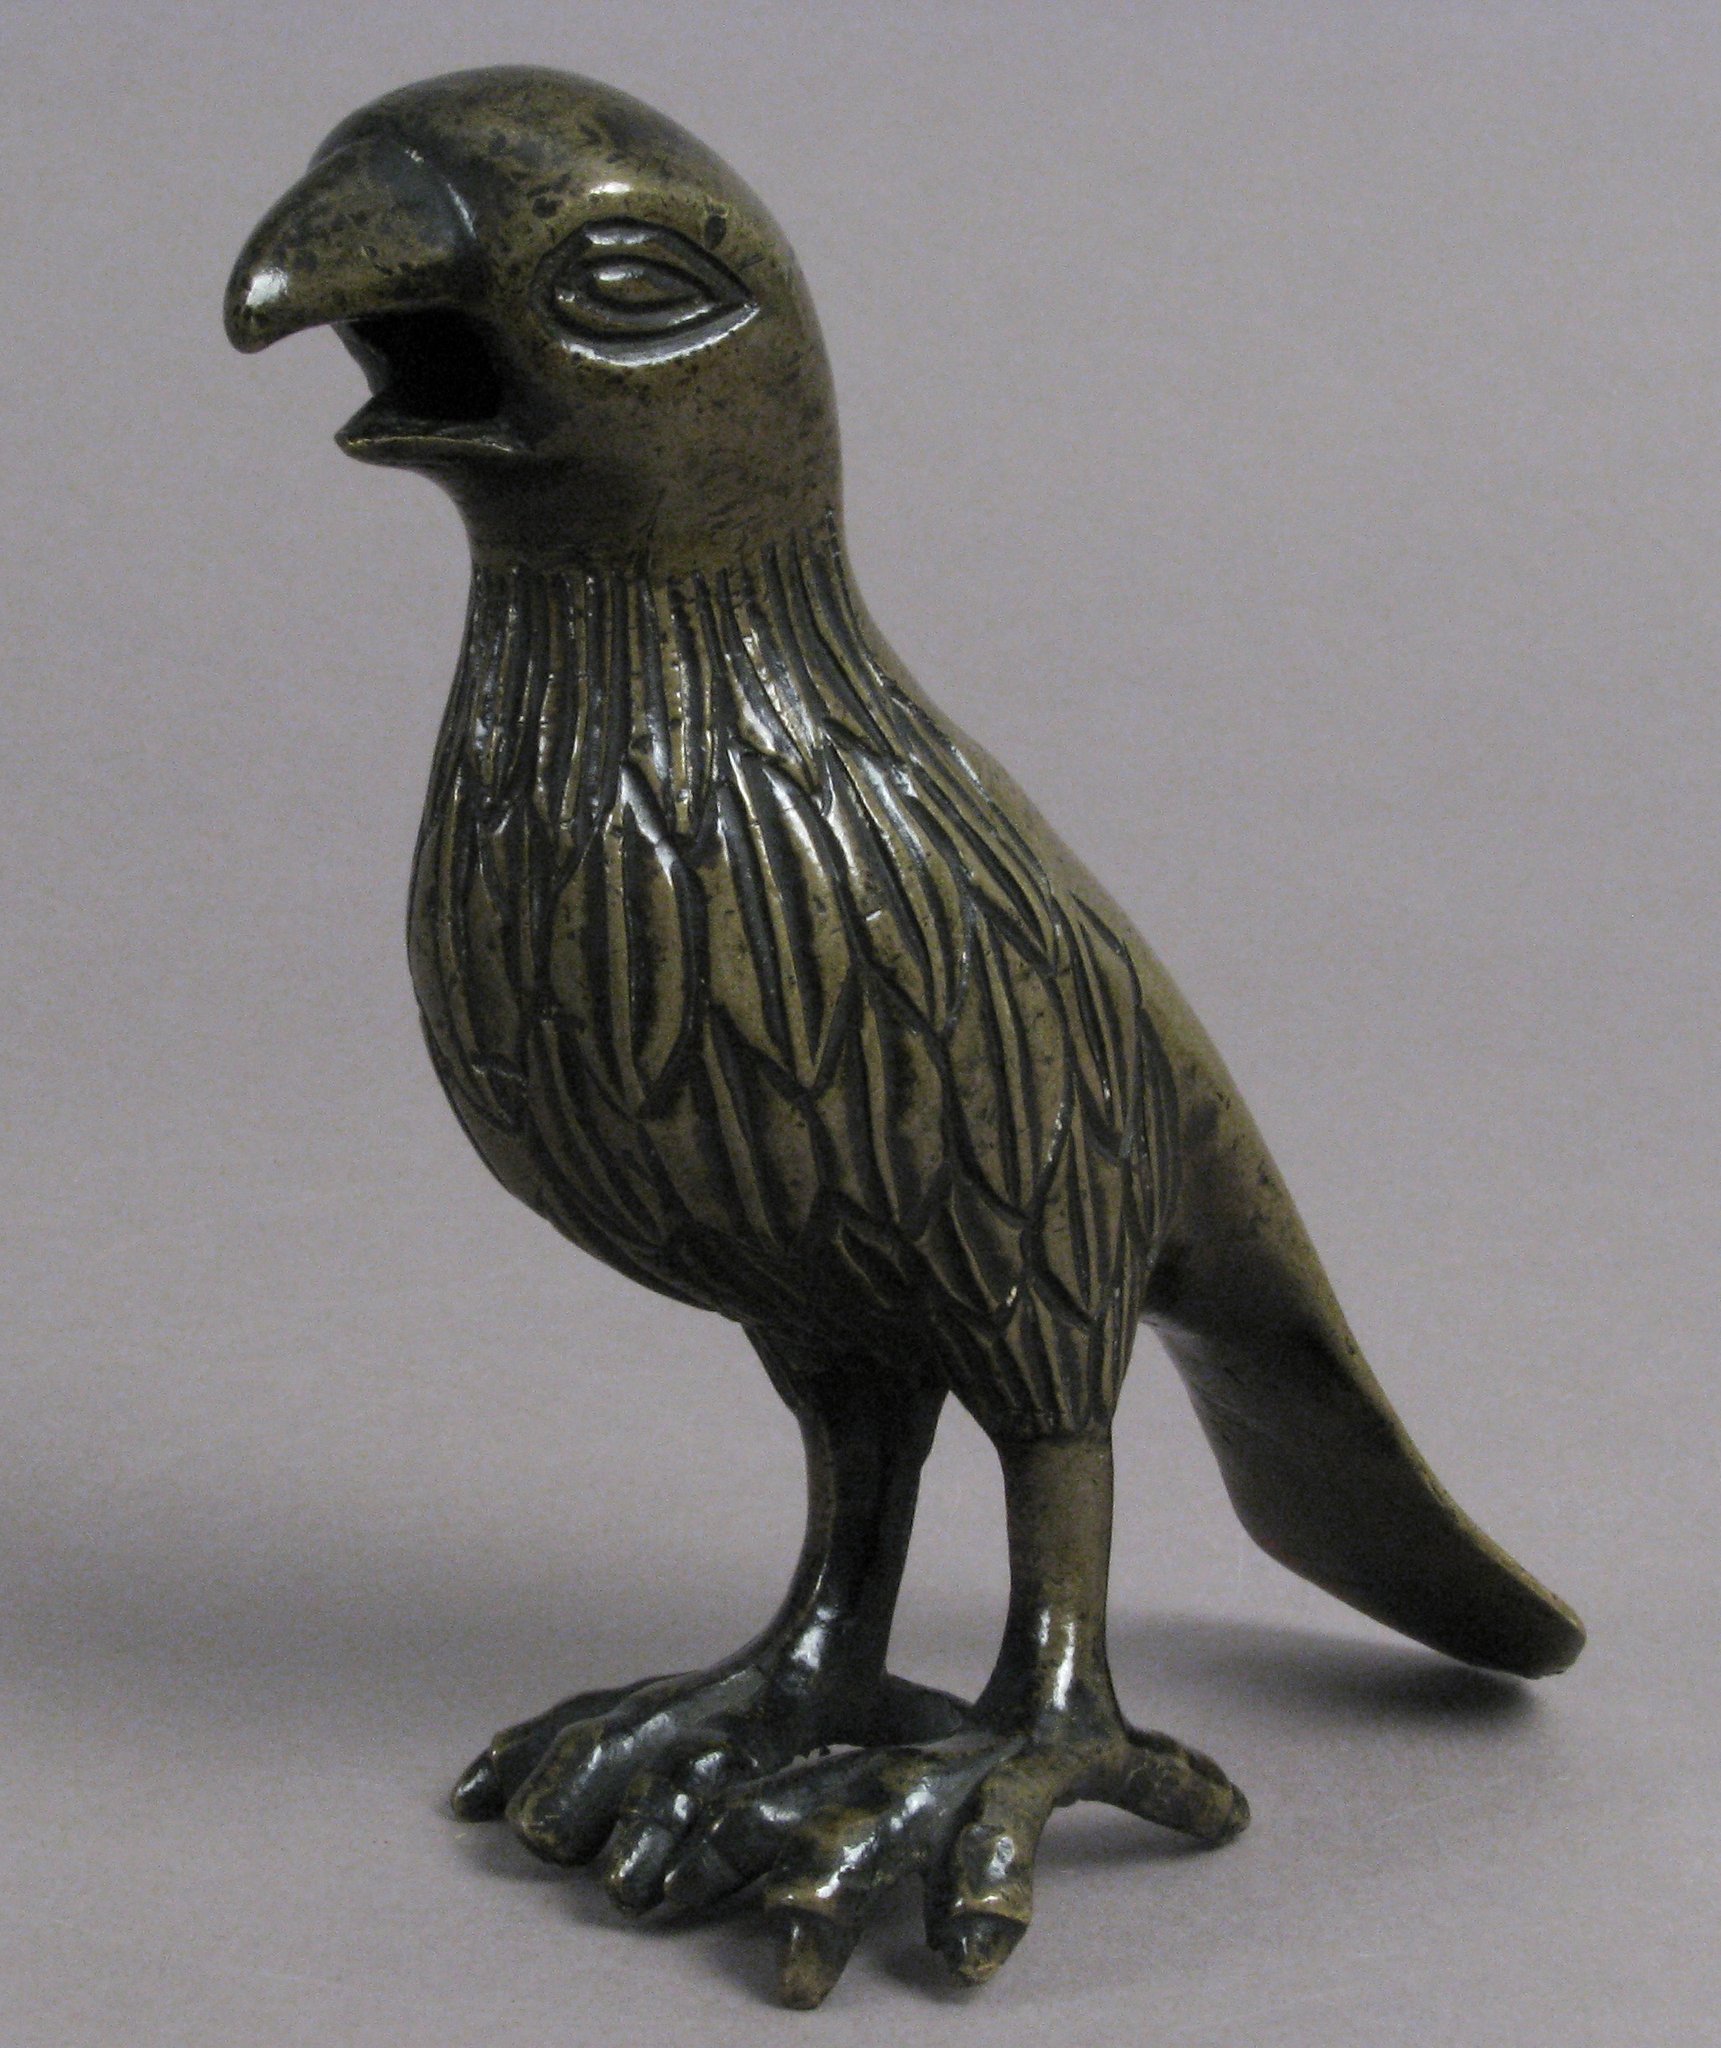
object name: figure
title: Bird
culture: south netherlandish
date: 1401-1500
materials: copper alloy